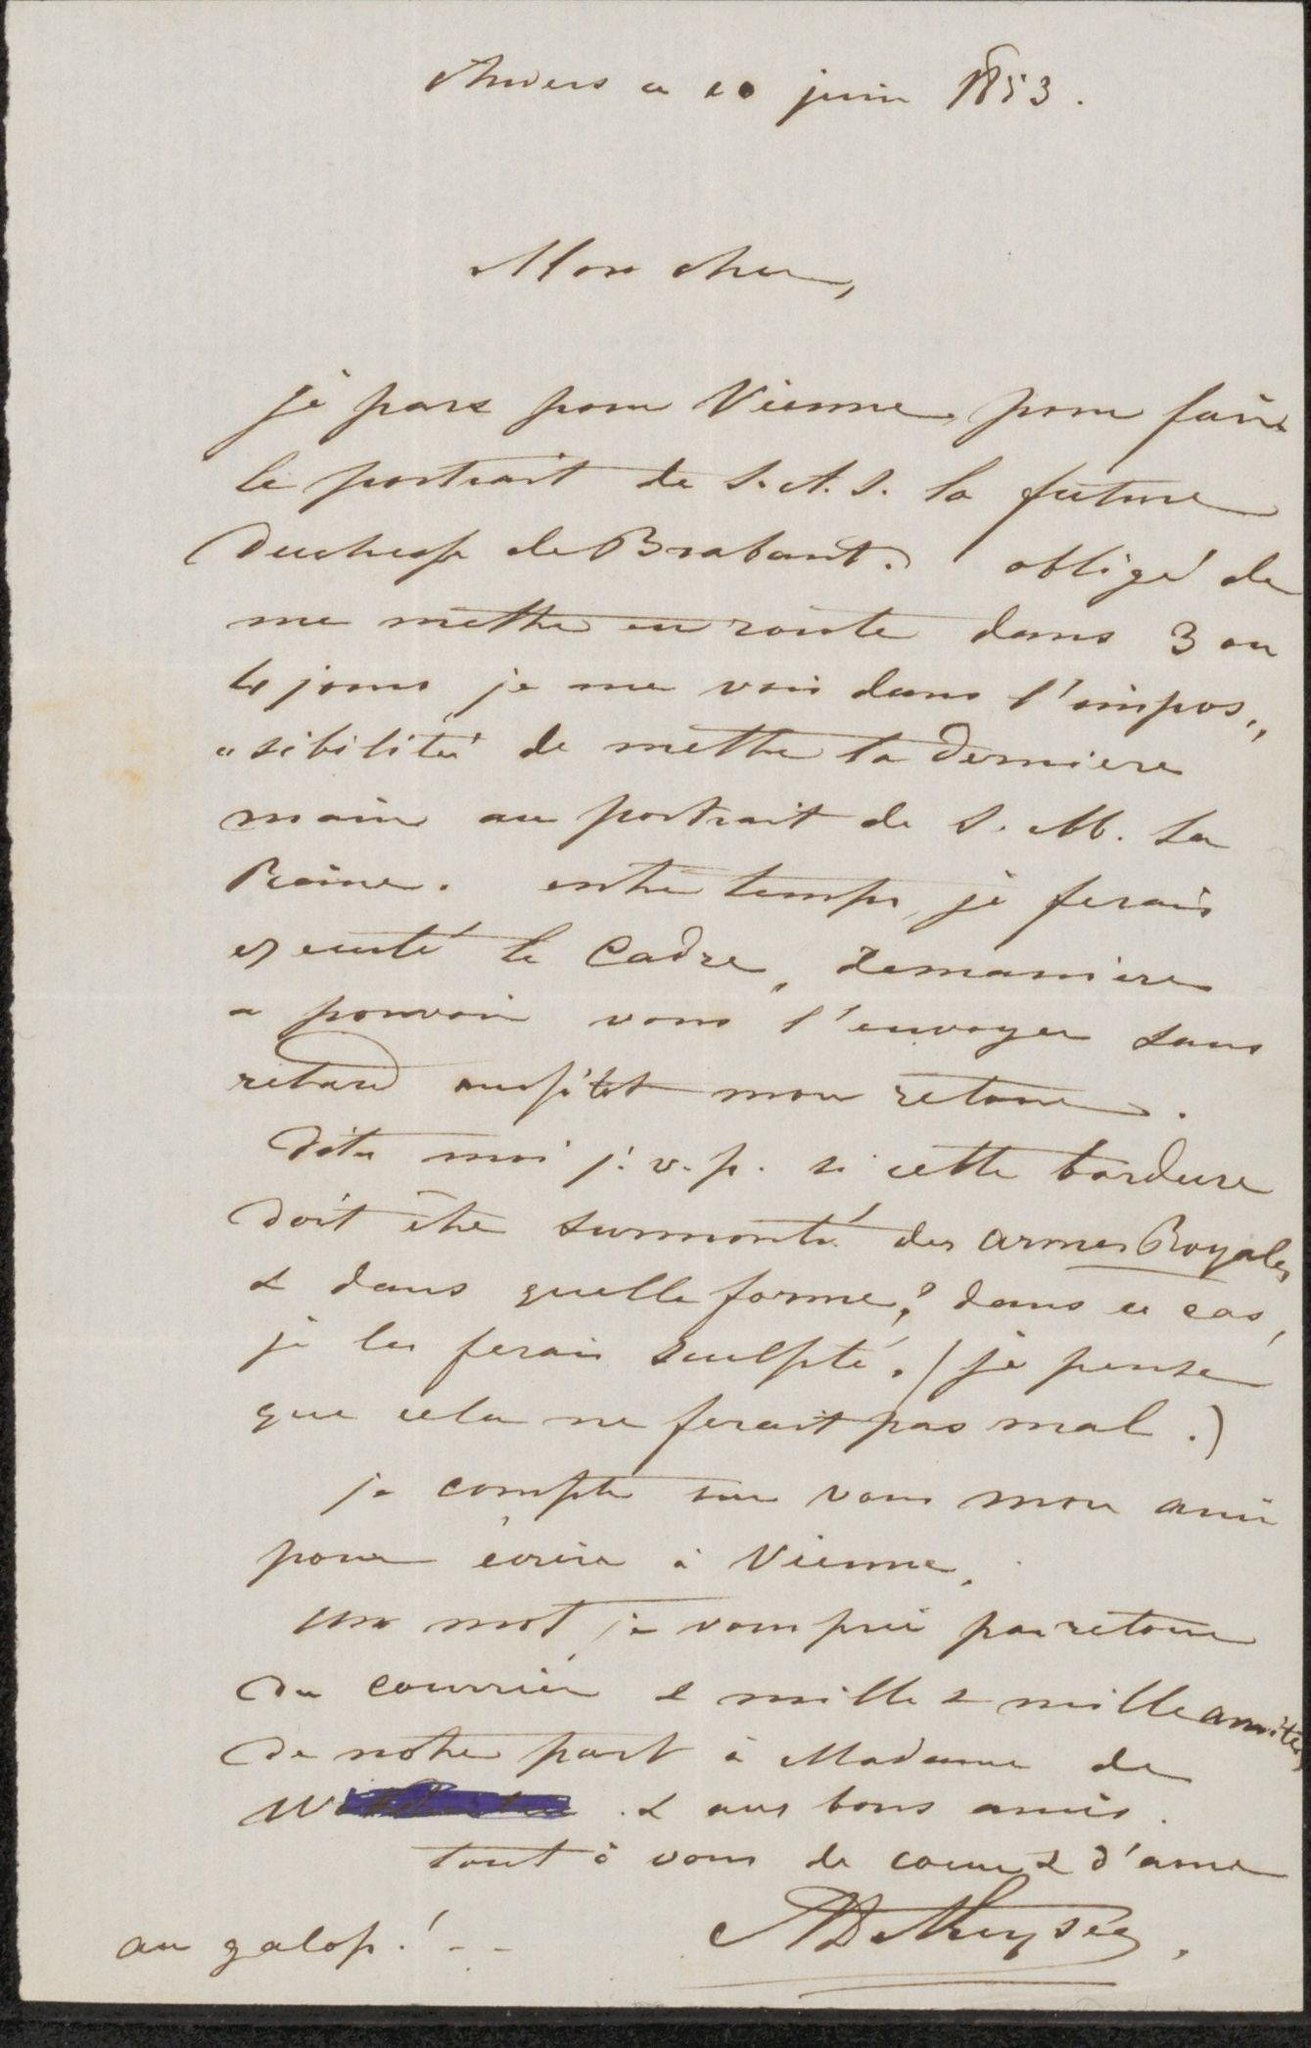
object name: letter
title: Brief aan anoniem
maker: nicaise de keyser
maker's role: draughtsman, painter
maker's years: 1813-1887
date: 1853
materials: ink, paper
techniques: pen, writing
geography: antwerp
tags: louise marie van orléans (koningin van belgië), historical persons (portraits and scenes from the life), vienna